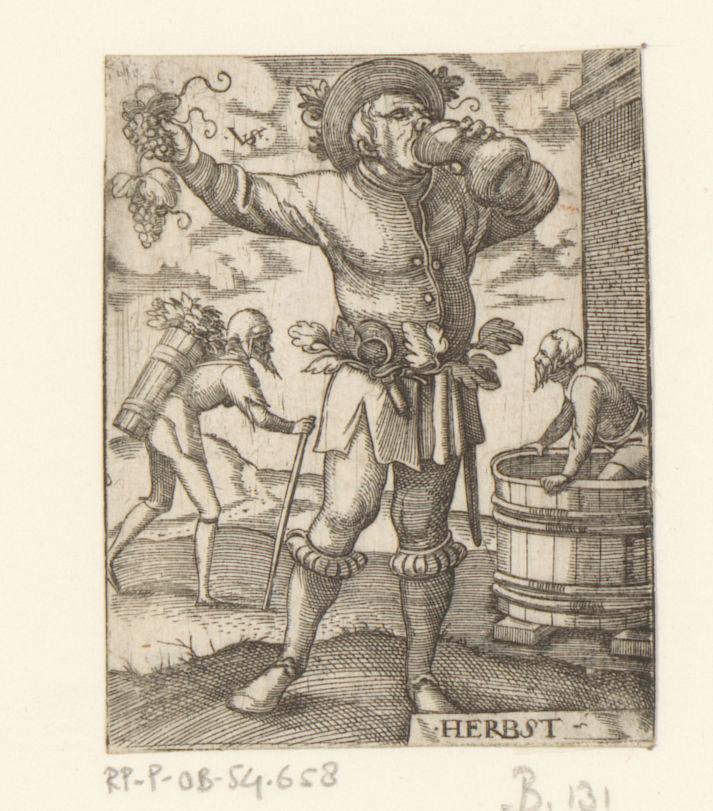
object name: print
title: Herbst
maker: virgilius solis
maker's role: draughtsman, print maker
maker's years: 1514-1562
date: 1524-1562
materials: paper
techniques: engraving, etching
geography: nuremberg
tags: autumn ~ human activities (the four seasons of the year)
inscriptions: collector's mark: Lugt 2228, number: ‘139’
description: Maakt deel uit van een serie van vier prenten met personificaties van de vier seizoenen.